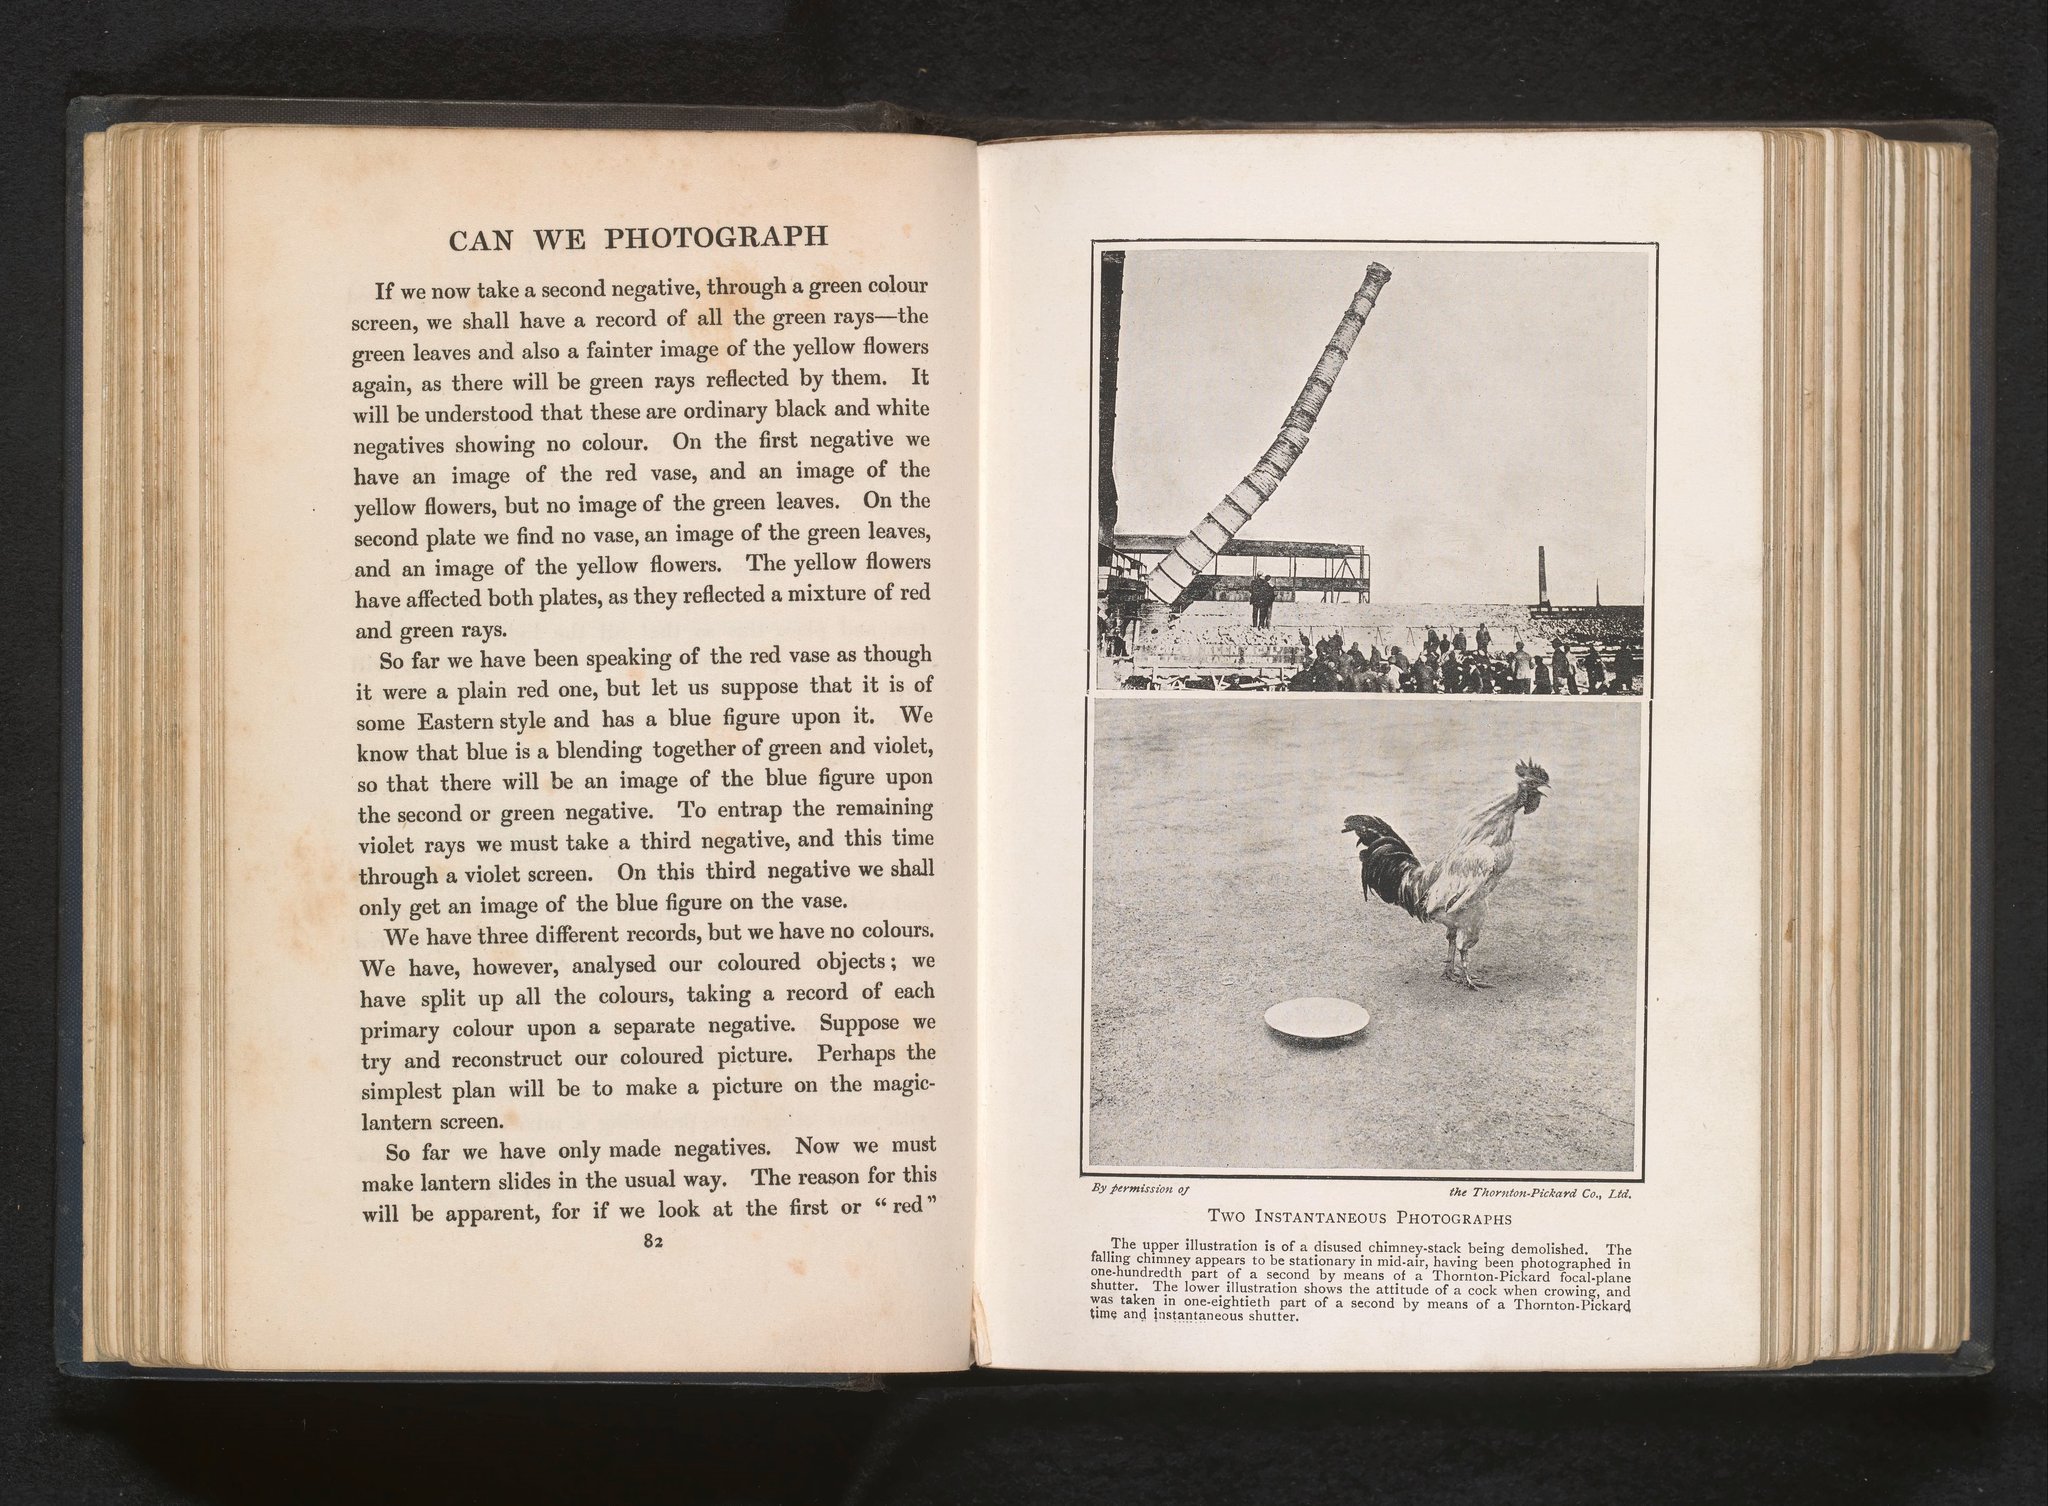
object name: photomechanical print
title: Vallende schoorsteen en een kraaiende haan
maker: Anonymous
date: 1898-1908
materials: paper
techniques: autotype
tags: chimney, fowl (cock, hen, chicken, etc.)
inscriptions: inscription: ‘The upper illustration is of a disused chimey-stack being demolished. The falling chimey appears to be stationary in mid-air, having been photographed in one-hundredth part of a second by means of a Thornton-Pickard focal-plane shutter. The lower illustration shows the attitude of a cock when crowing, and was taken in one-eightieth part of a second by means of a Thornton-Pickard time and instantaneous shutter.’